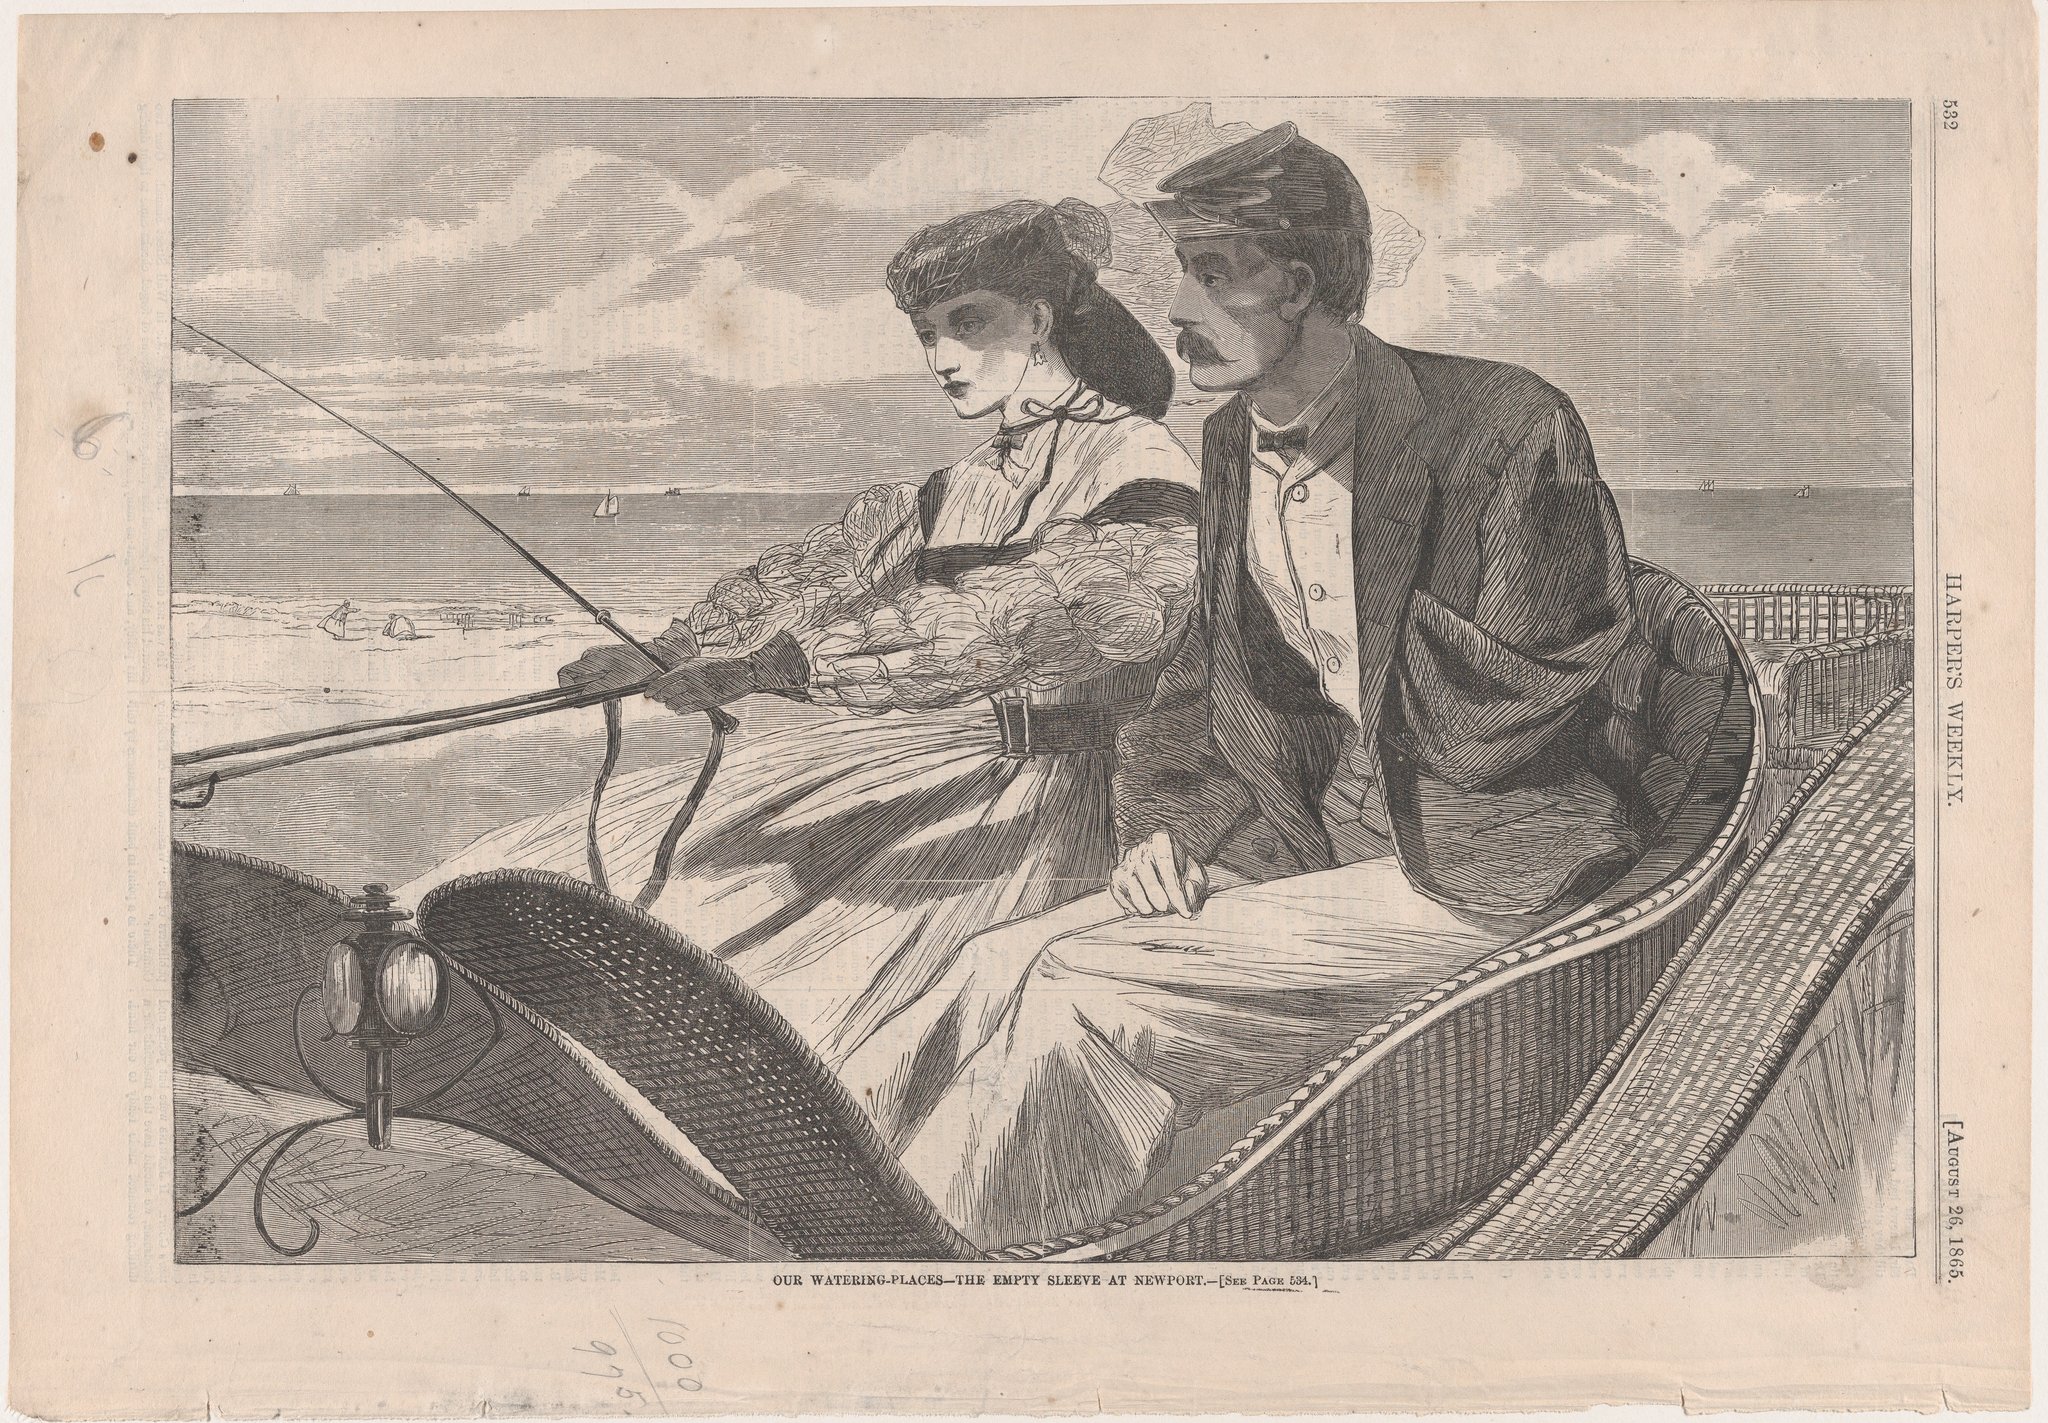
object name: print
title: Our Watering Places – The Empty Sleeve at Newport (from "Harper's Weekly," Vol. IX)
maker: winslow homer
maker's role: artist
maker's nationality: american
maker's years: 1836-1910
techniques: engraving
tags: men,women,carriages